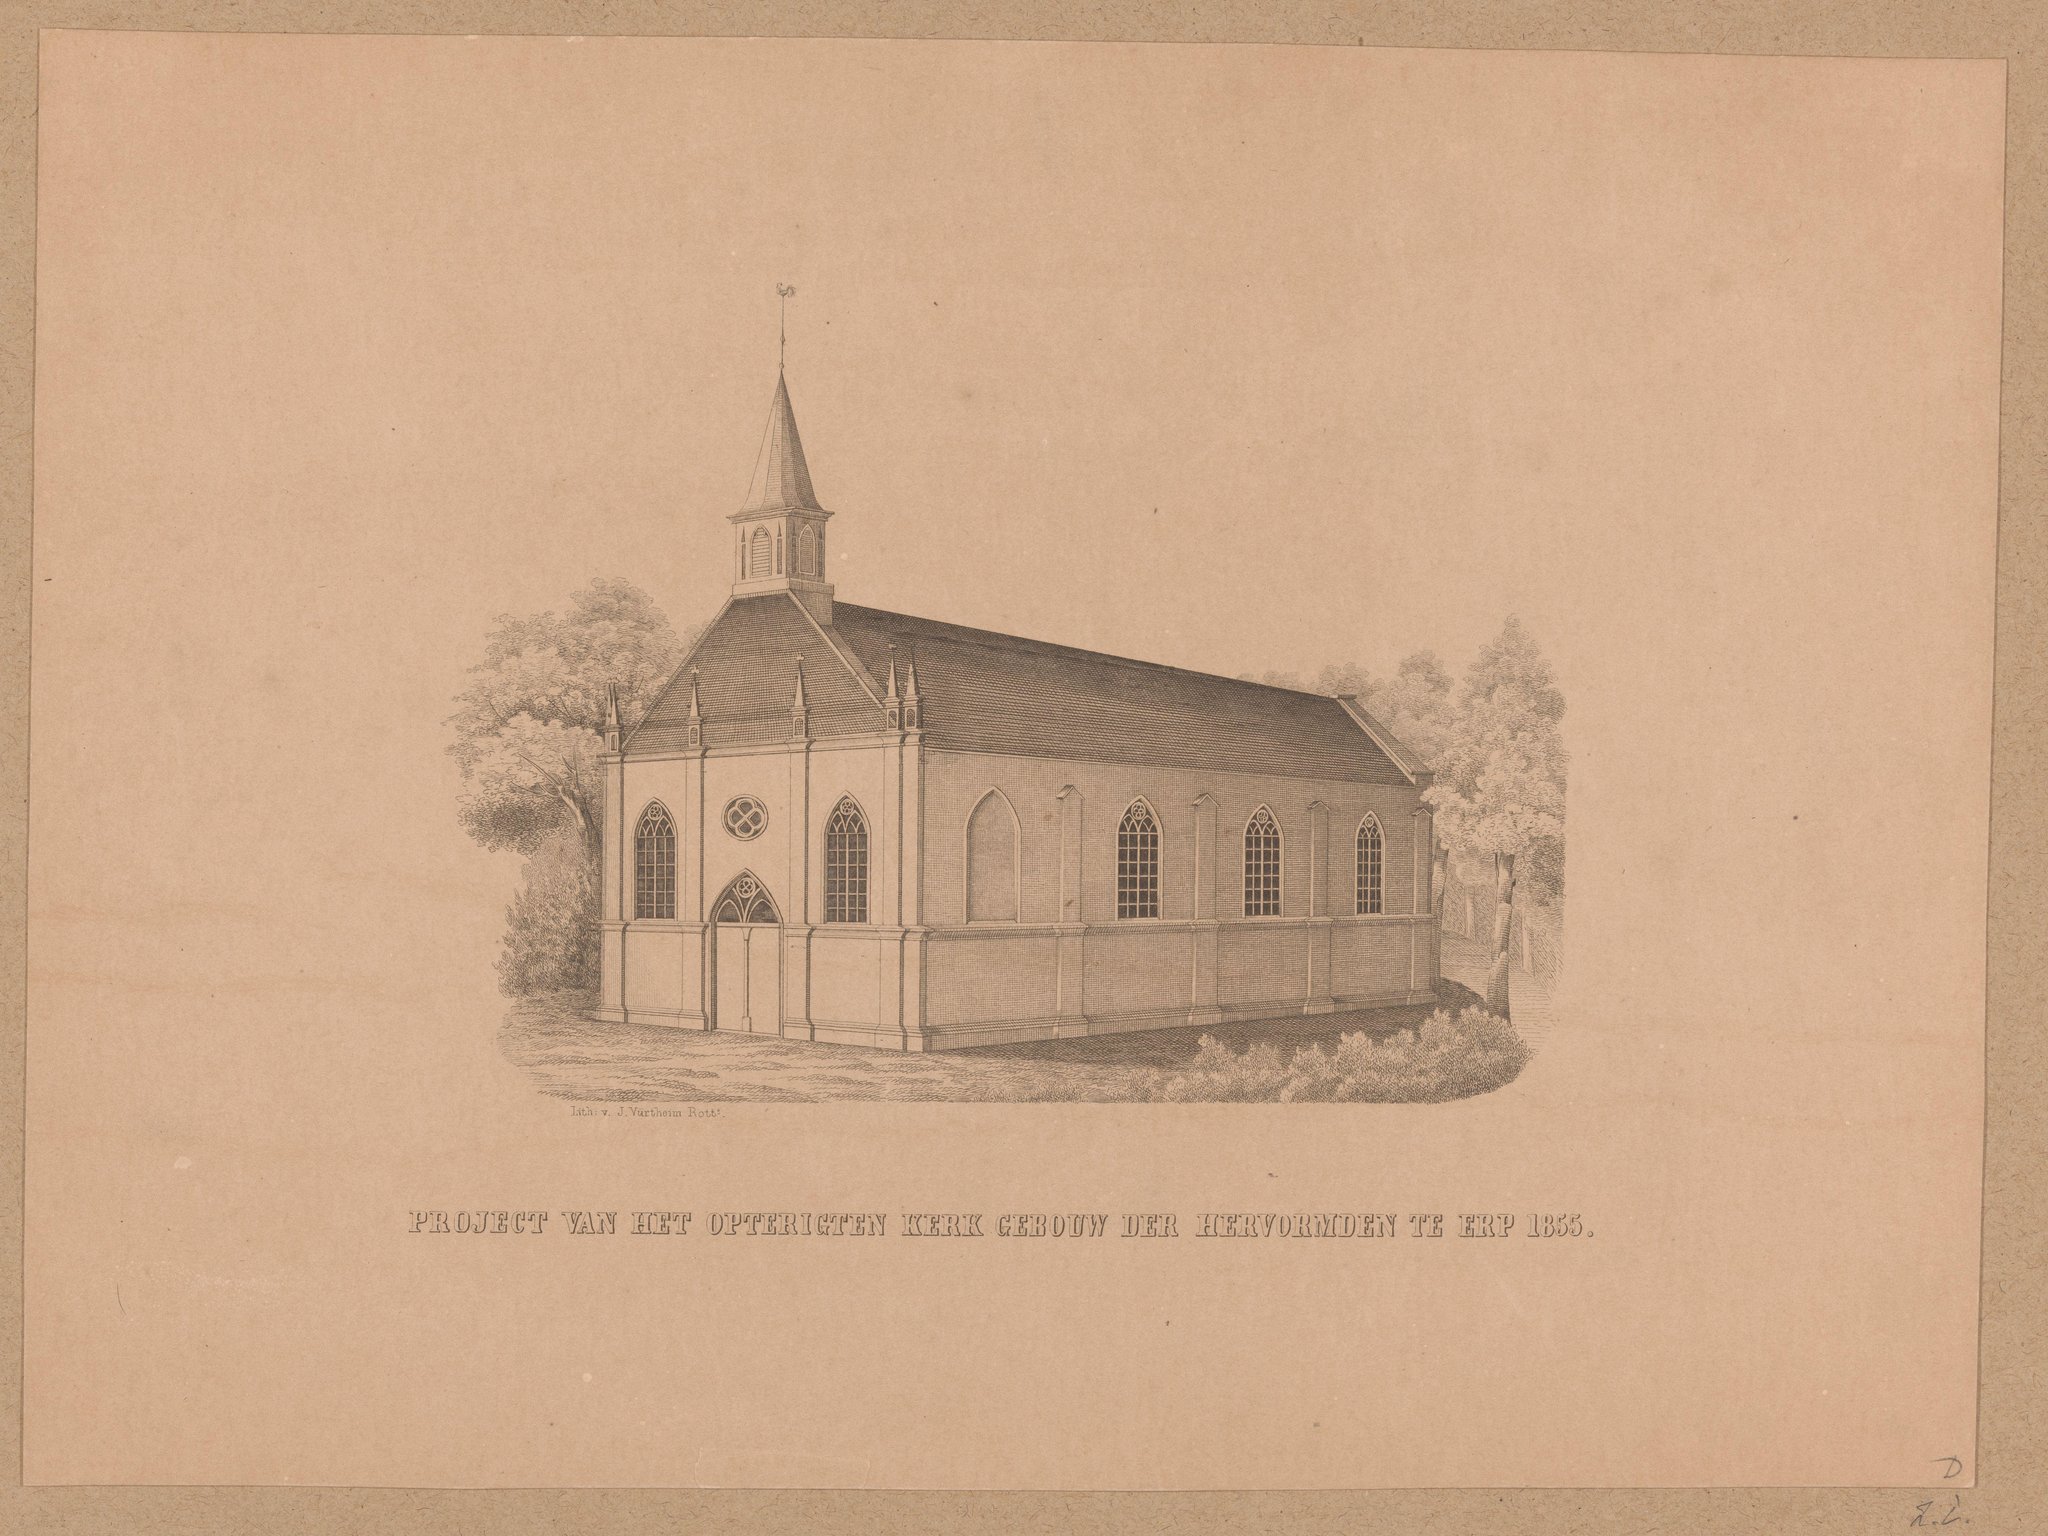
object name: print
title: Ontwerp van de Hervormde kerk in Erp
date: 1855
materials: paper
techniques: lithograph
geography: rotterdam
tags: church (exterior), veghel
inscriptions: date